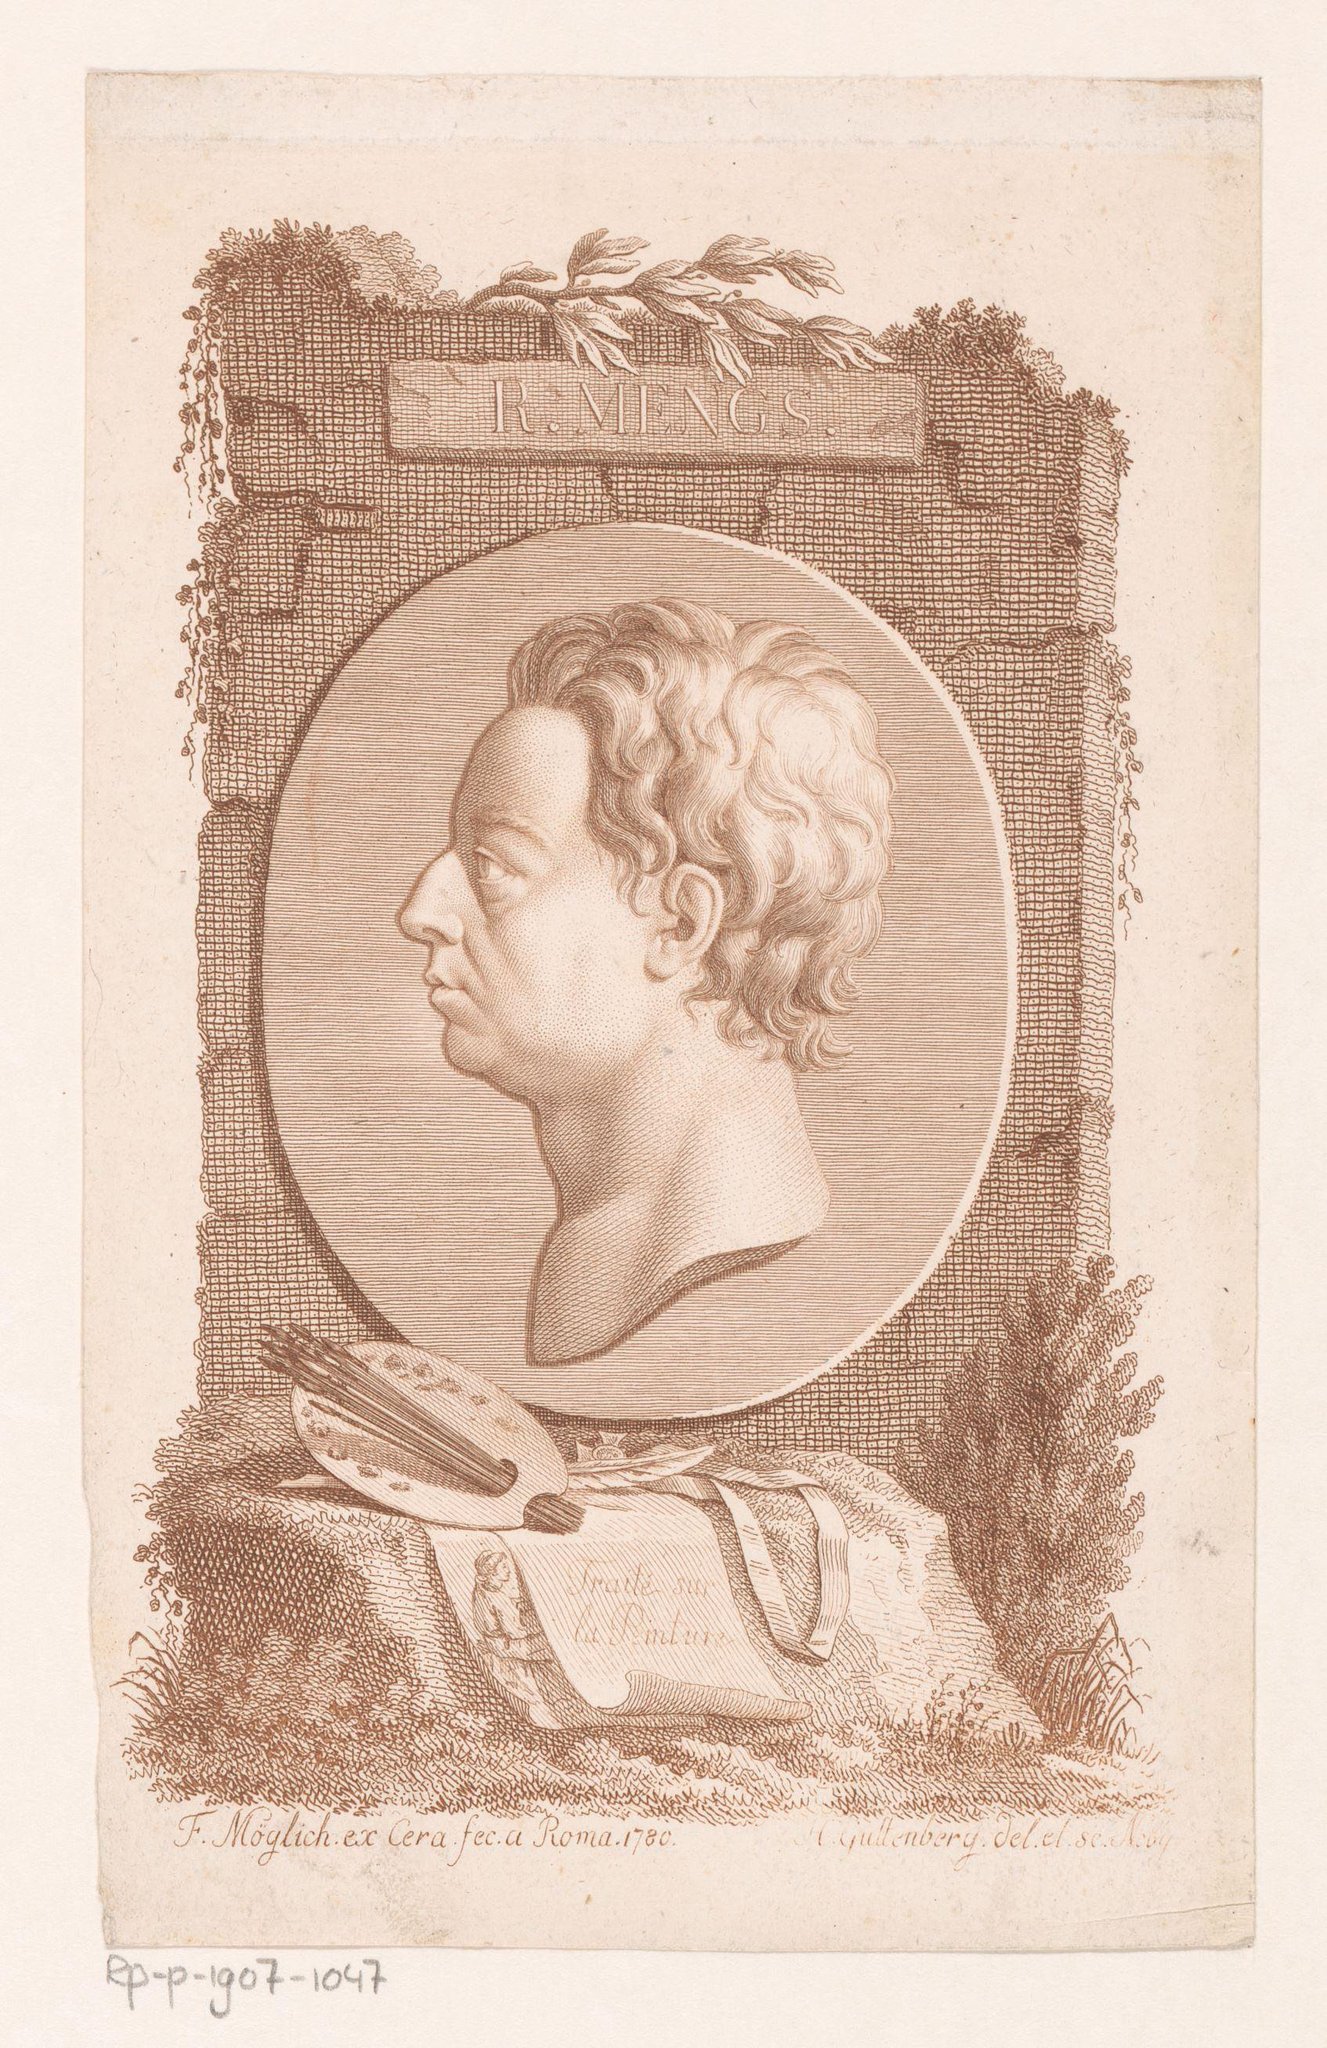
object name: print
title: Portret van Anton Raphael Mengs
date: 1780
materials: paper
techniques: etching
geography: rome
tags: painter, draughtsman, anton raphael mengs, historical persons, tools, implements of painter, medals and other marks of military honour, decorating 'en relief', appliquéing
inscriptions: collector's mark: Lugt 2228